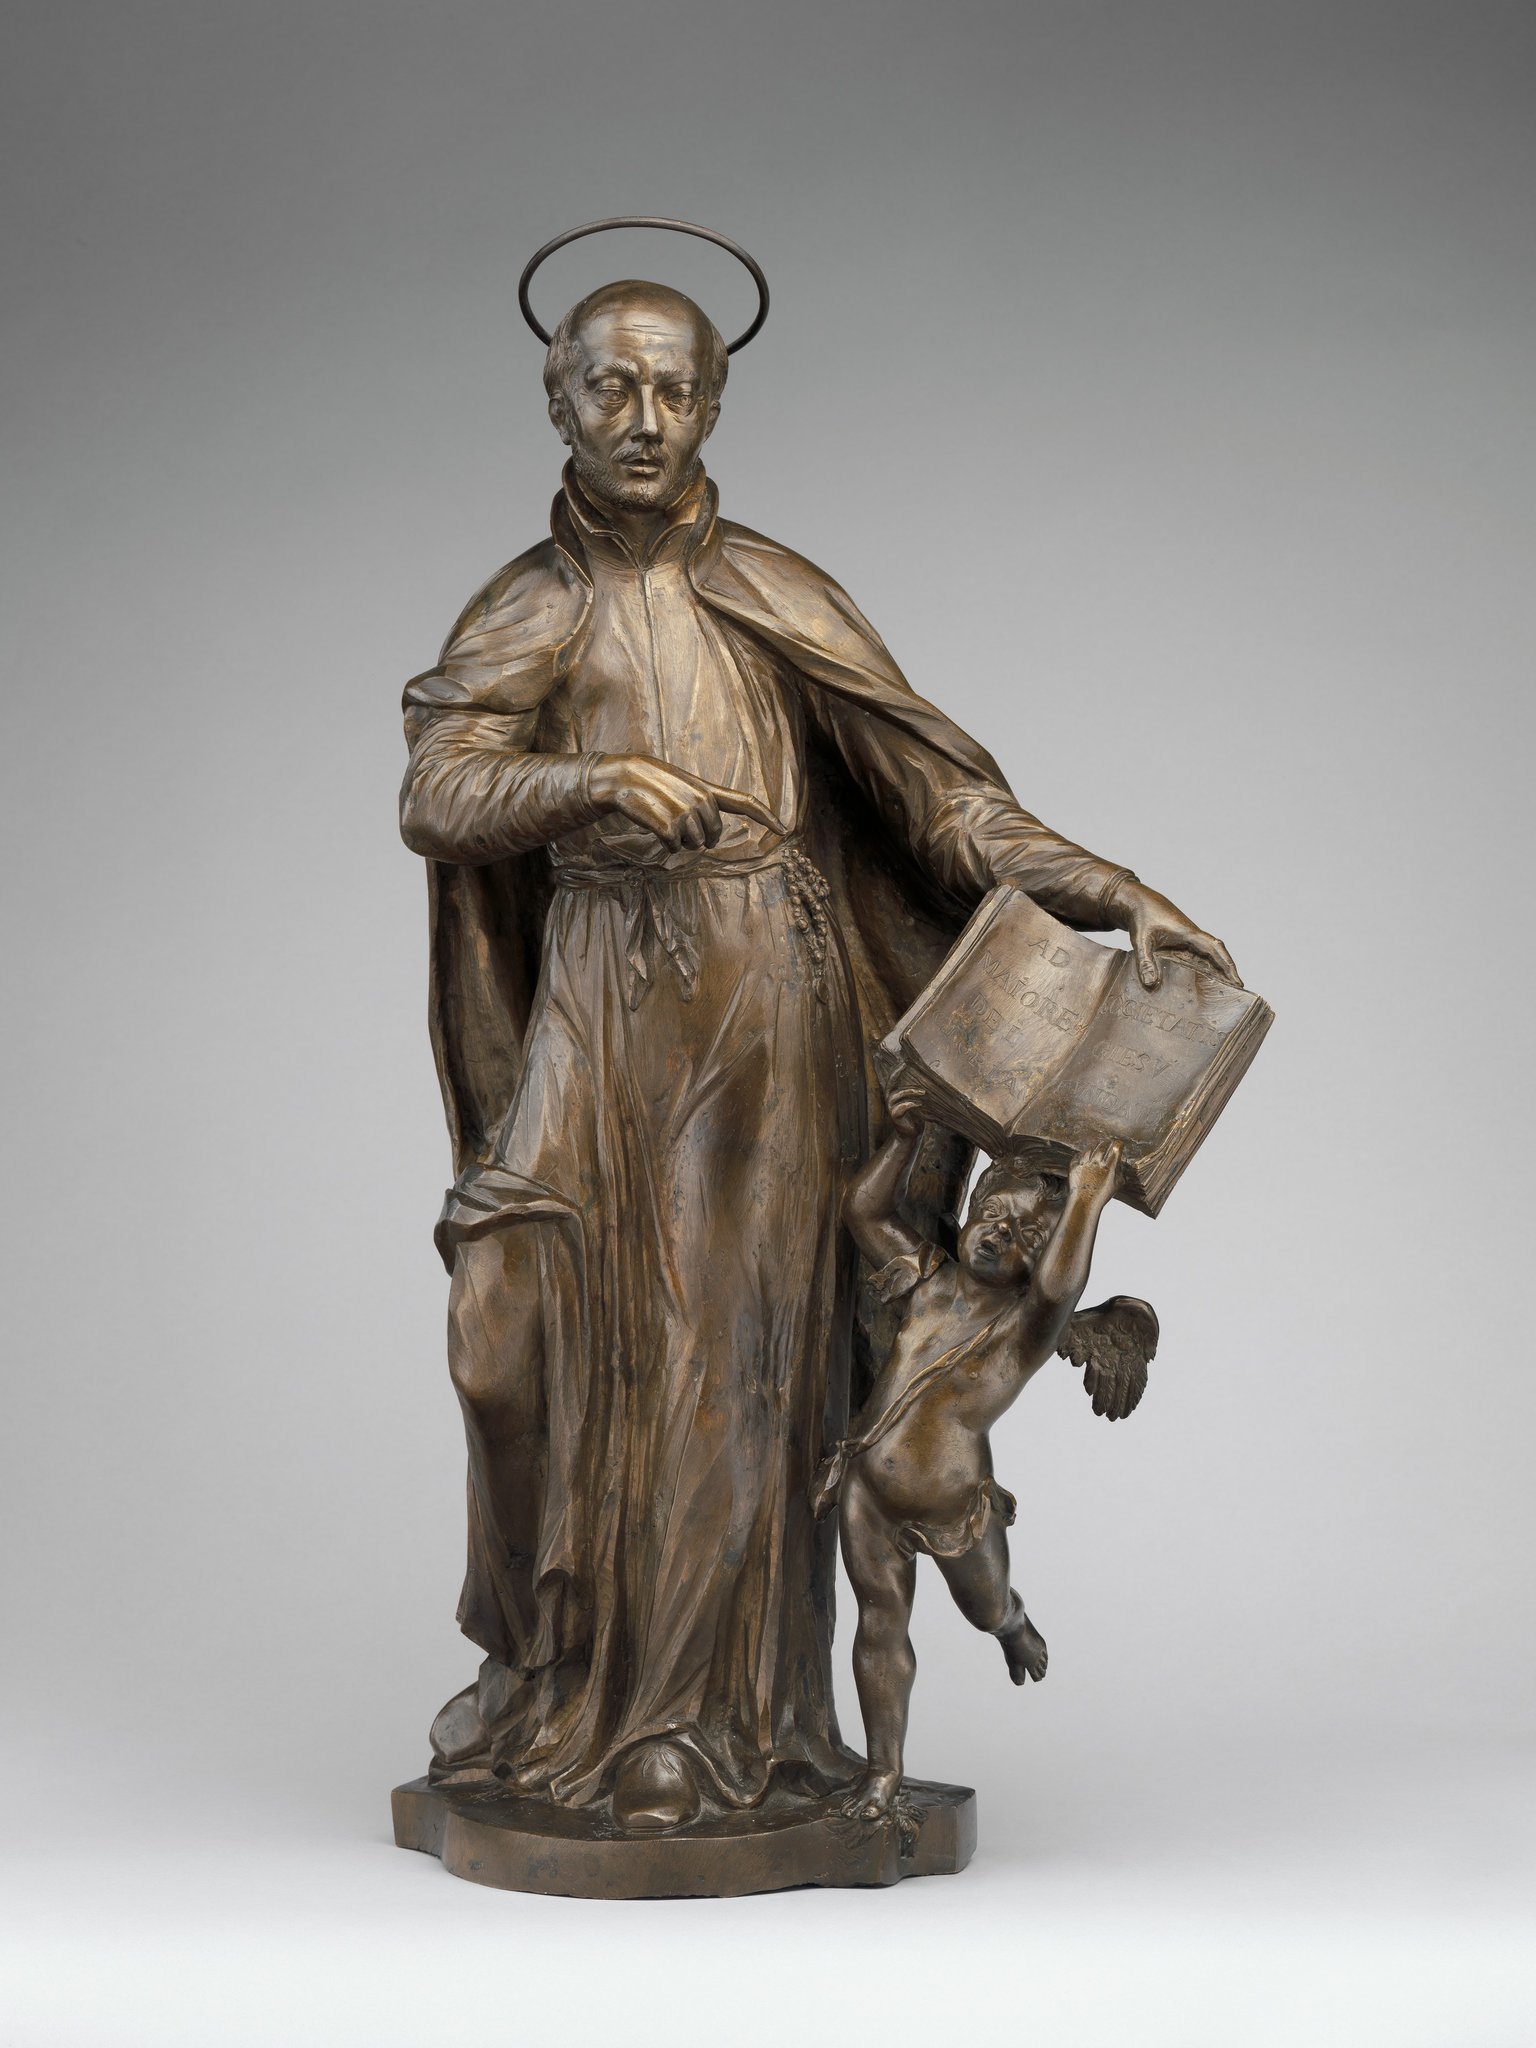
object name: statue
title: Saint Ignatius Loyola with an angel holding a book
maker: francesco bertos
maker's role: maker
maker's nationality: italian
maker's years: 1678-1741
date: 1722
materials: bronze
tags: books,angels,saints